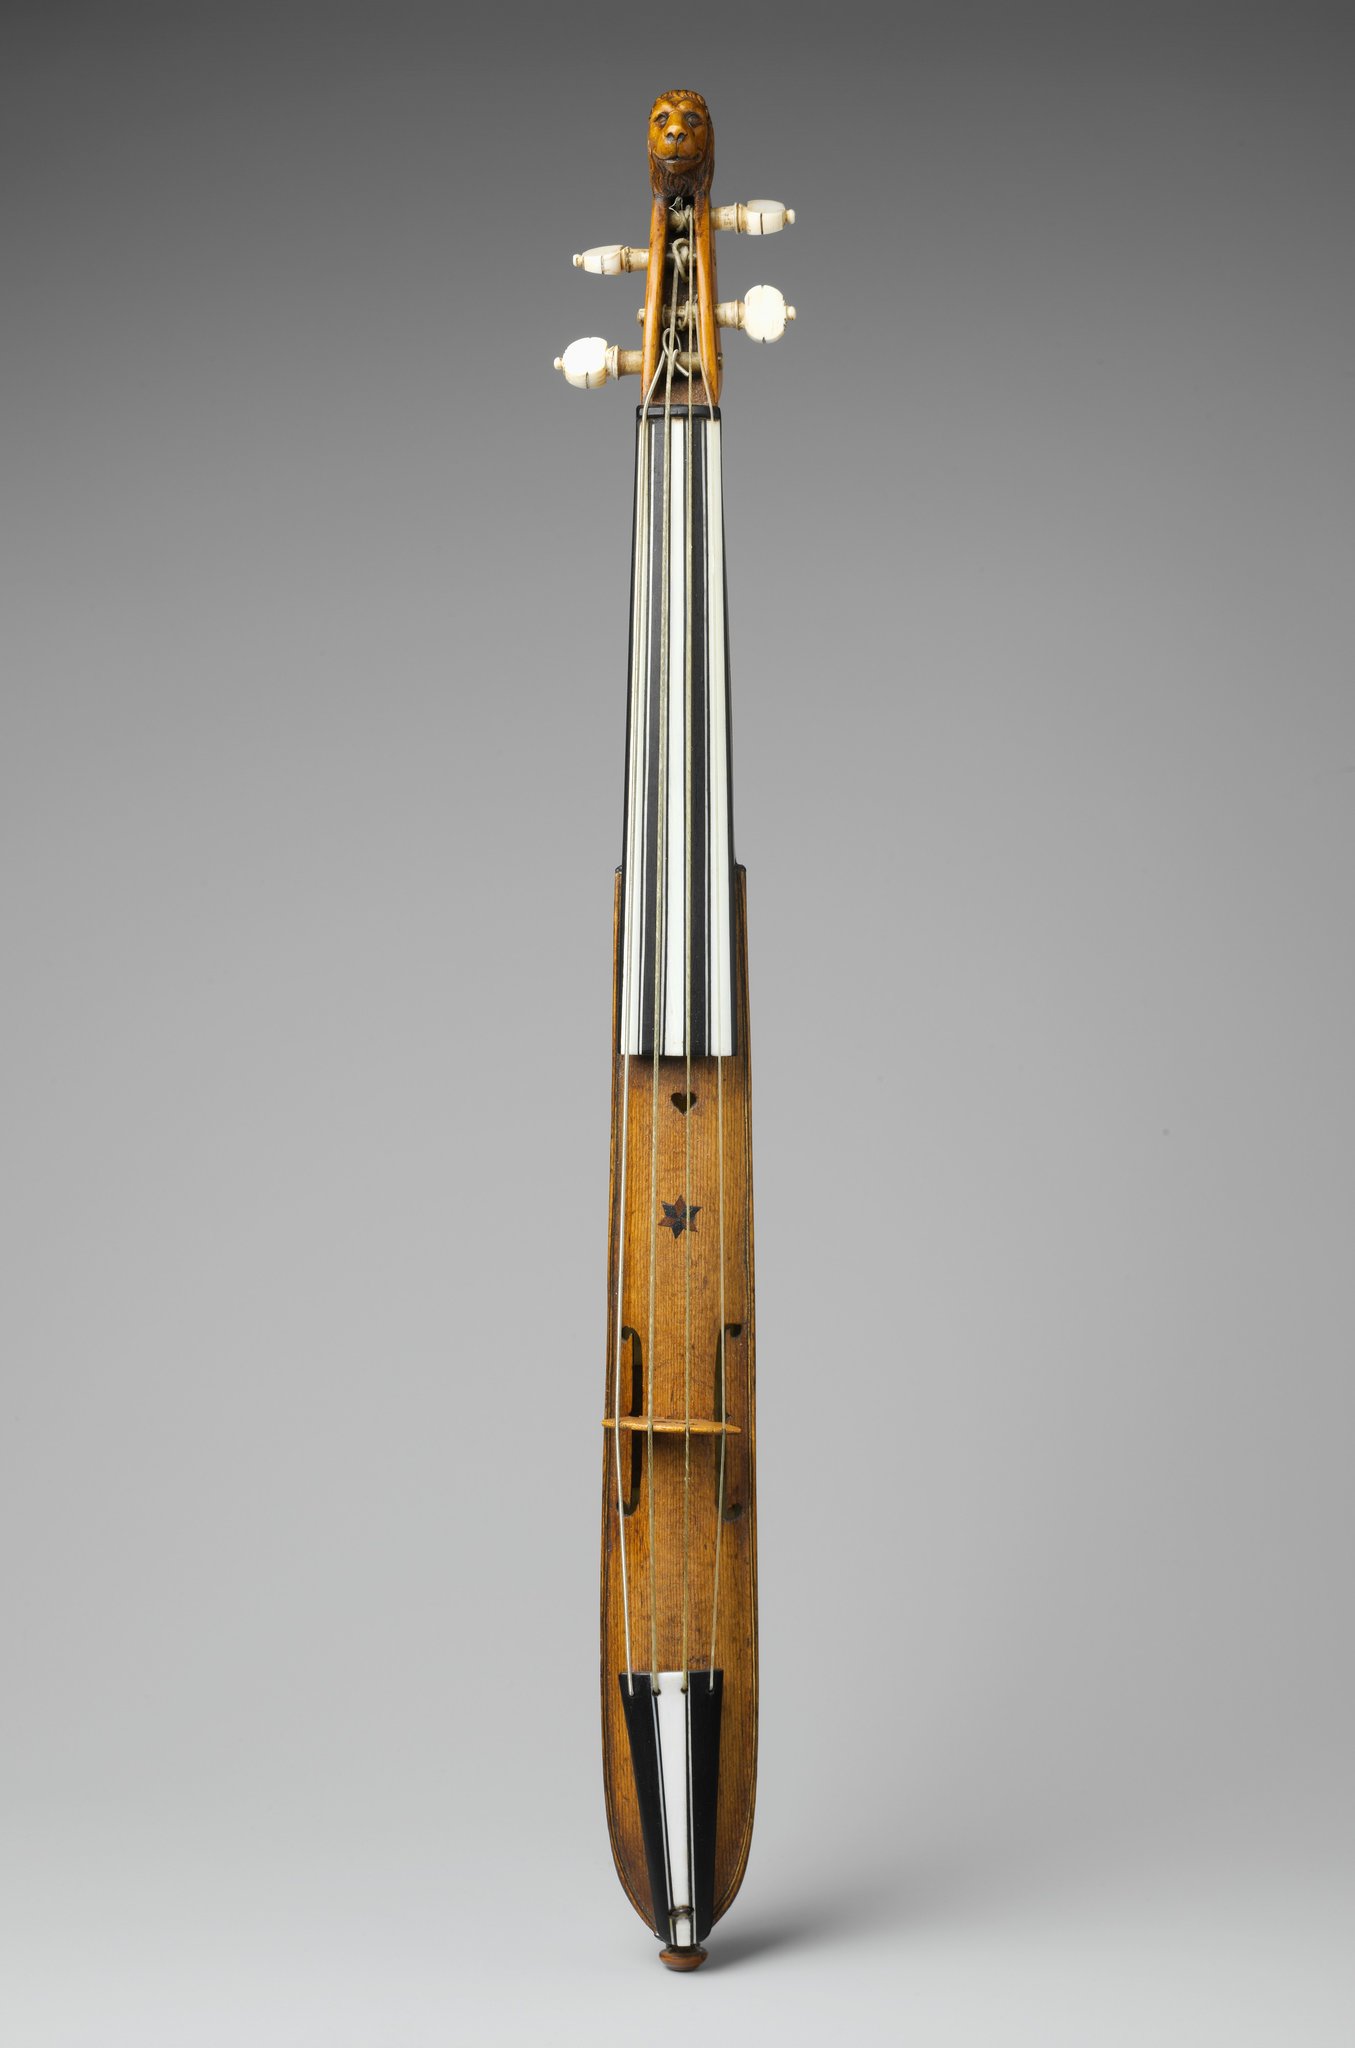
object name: pochette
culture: german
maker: georg wörle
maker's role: maker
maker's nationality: german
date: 1670-1679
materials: wood, ivory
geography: germany